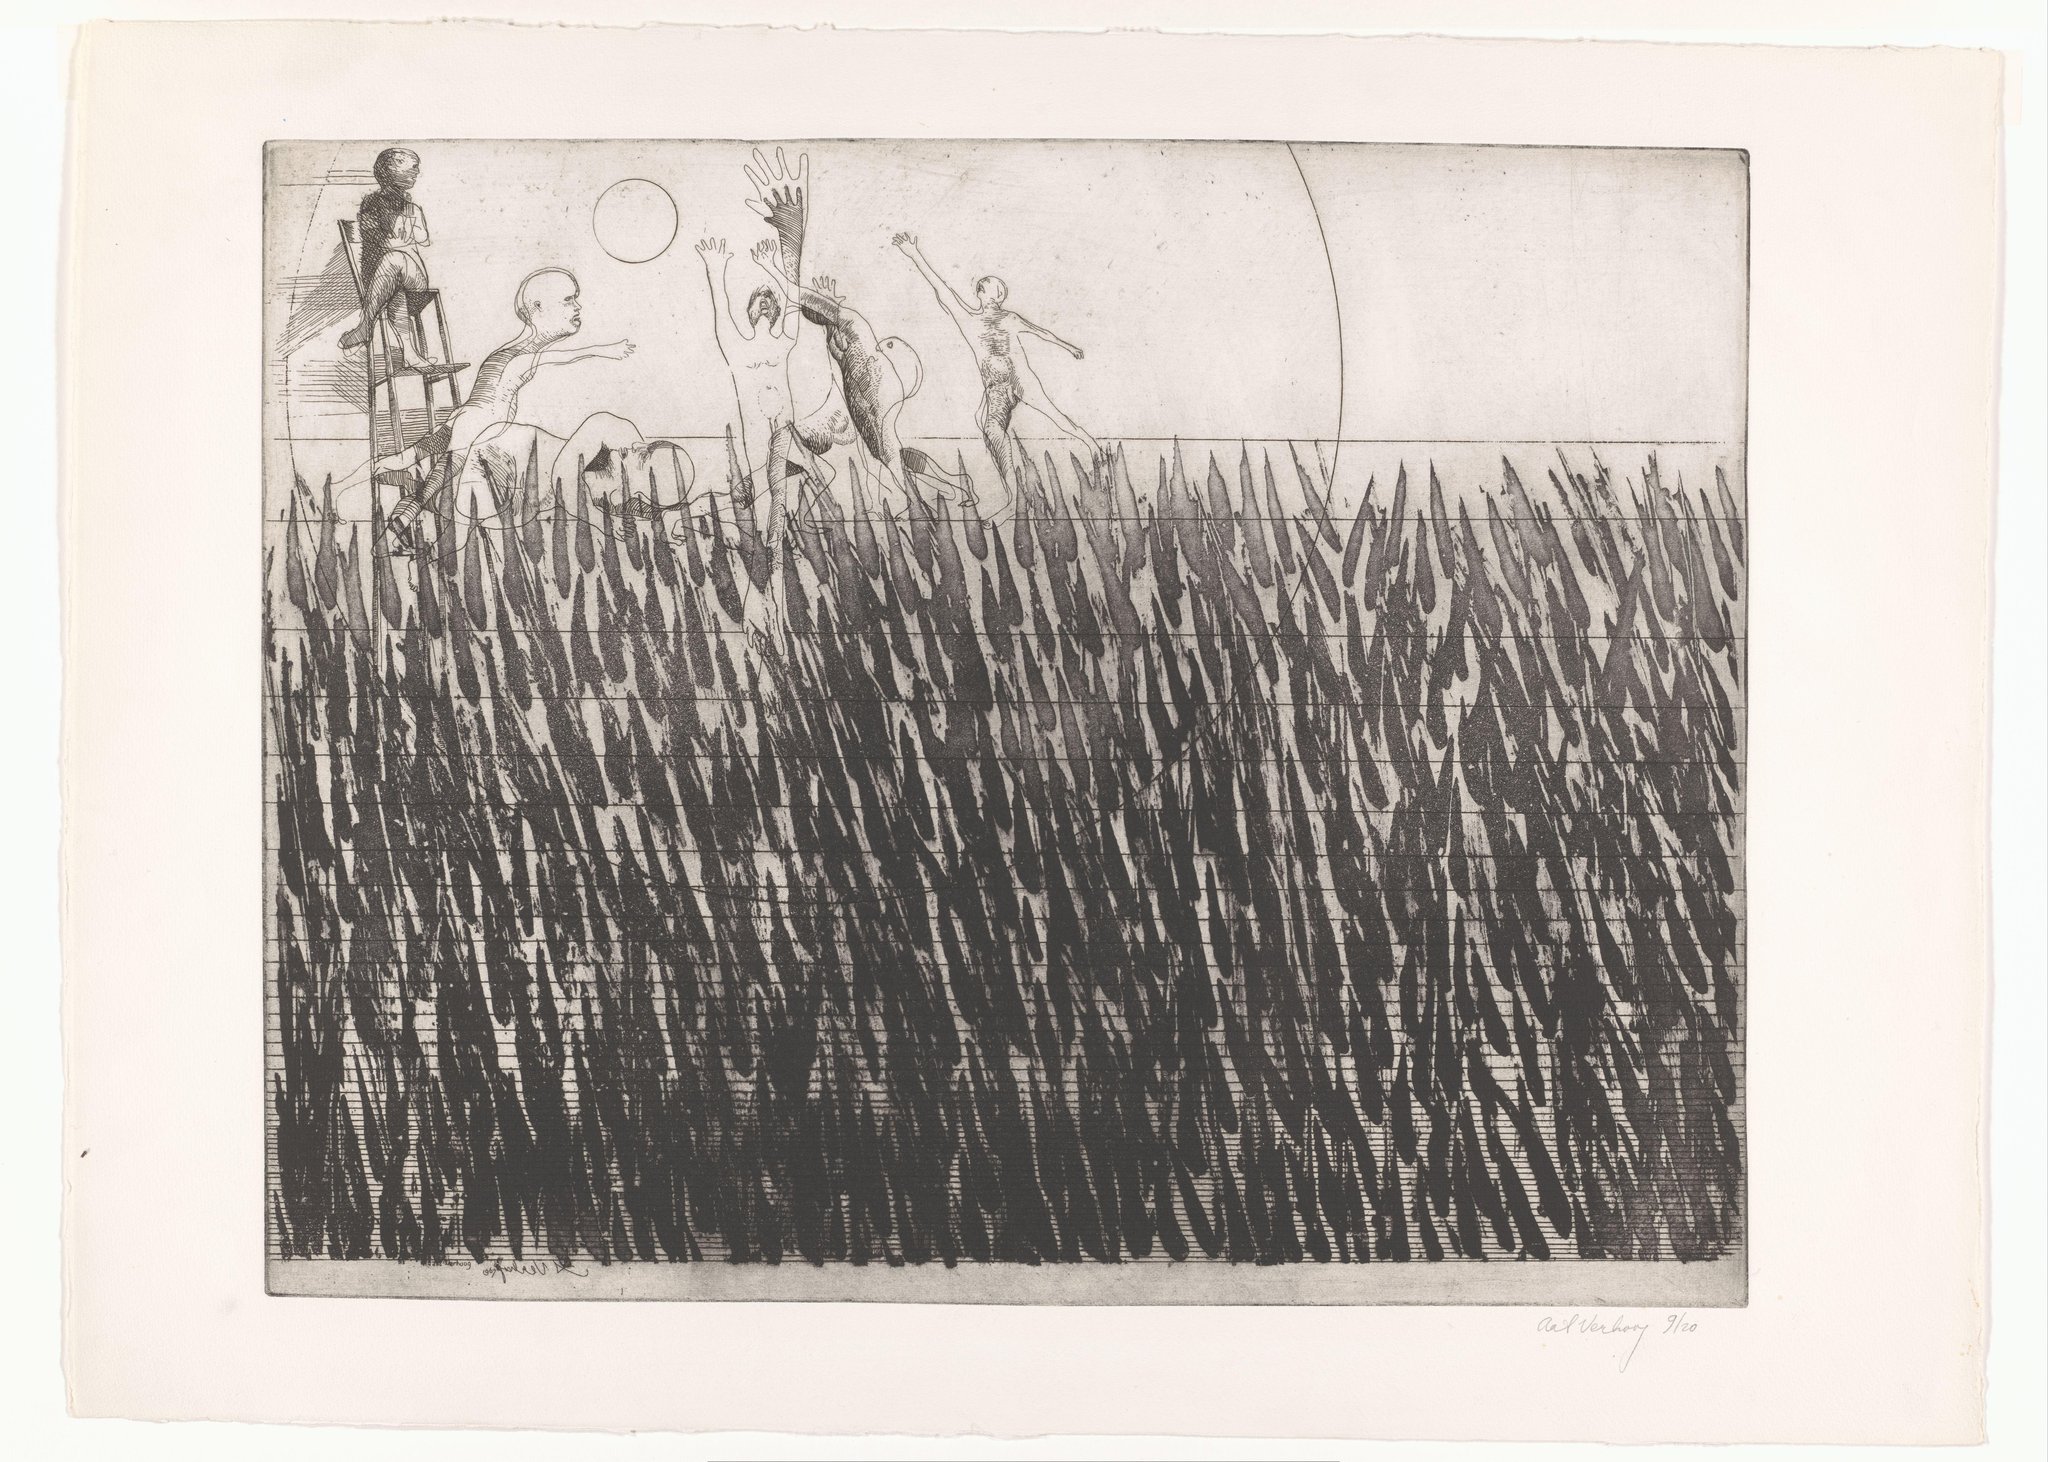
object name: print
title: Balspel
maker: aat verhoog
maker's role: print maker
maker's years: 1933-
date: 1967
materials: paper, ink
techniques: aquatint, etching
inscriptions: signature: ‘Aat Verhoog’, edition: ‘9/20’, signature and date: ‘Aat Verhoog 1967’, signature: ‘Aat Verhoog’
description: Compositie met zwarte verticale puntige strepen over horizontale lijnen met daarboven enkele antropomorfe naakte wezens en een bal.